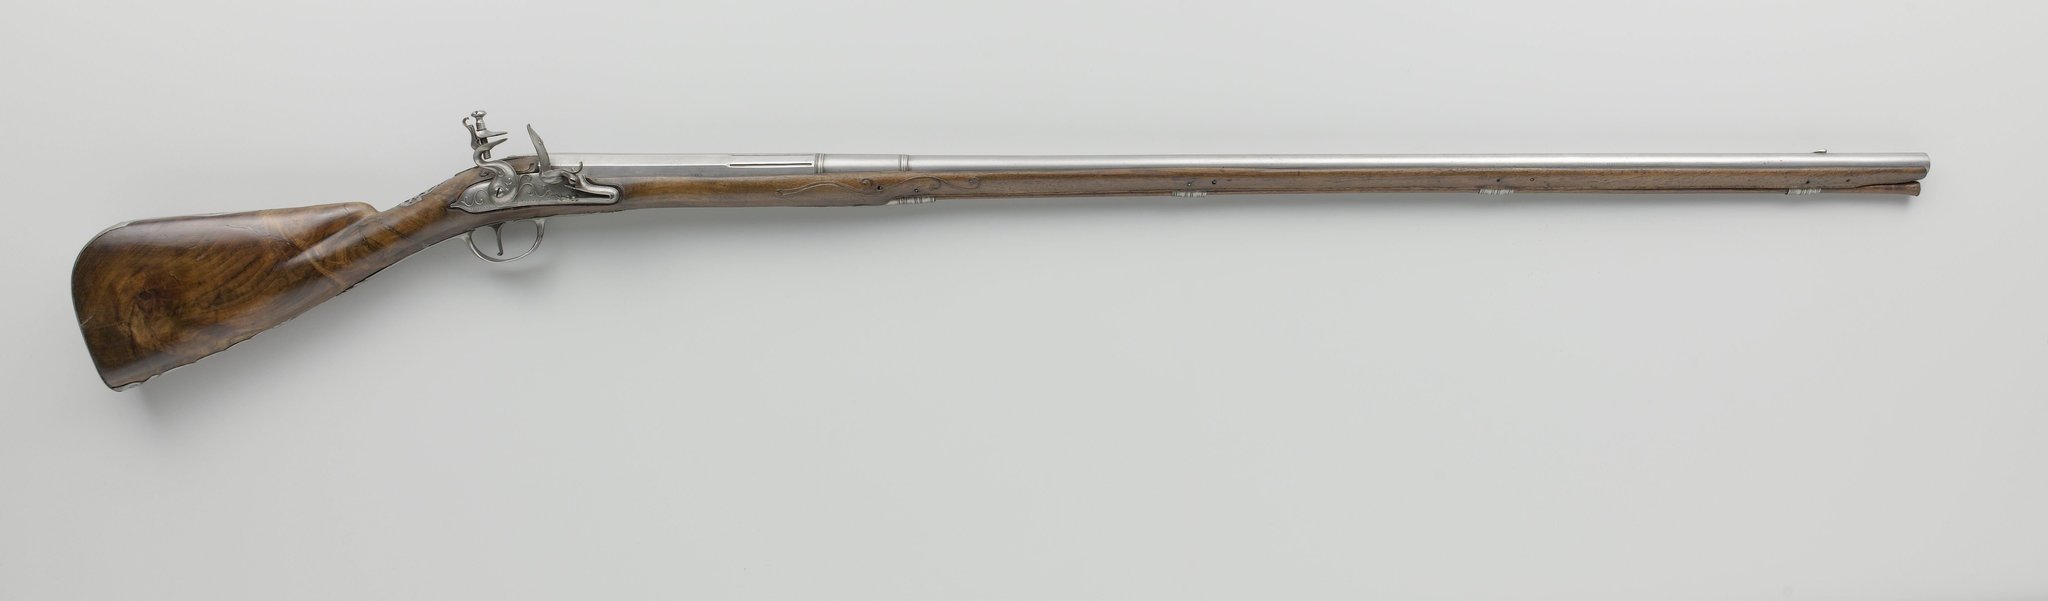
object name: jachtgeweer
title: Vuursteenjachtgeweer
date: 1690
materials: iron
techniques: printing, cutting, embroidery, engraving, striking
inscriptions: signature: ‘IAM.KRANS A MAESTRiCHT’, mark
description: De slotplaat is eenvoudig in reliëf gebeiteld met ranken en voorzien van een signatuur. De loop heeft een ijzeren vizierkorrel. De wortelnotenhouten kolf is eenvoudig gesneden en gebrandmerkt met twee vissen boven een gestempelde 4 achter de trekkerbeugel. Het ijzeren beslag bestaat onder meer uit vier laadstokkokers, een schroefplaat in de vorm van een zeeslang, een ajour bewerkte, gekroonde duimplaat omlijst door ranken en een teenplaat onderop de greep met verstrengelde ranken eindigend in een drieblad.